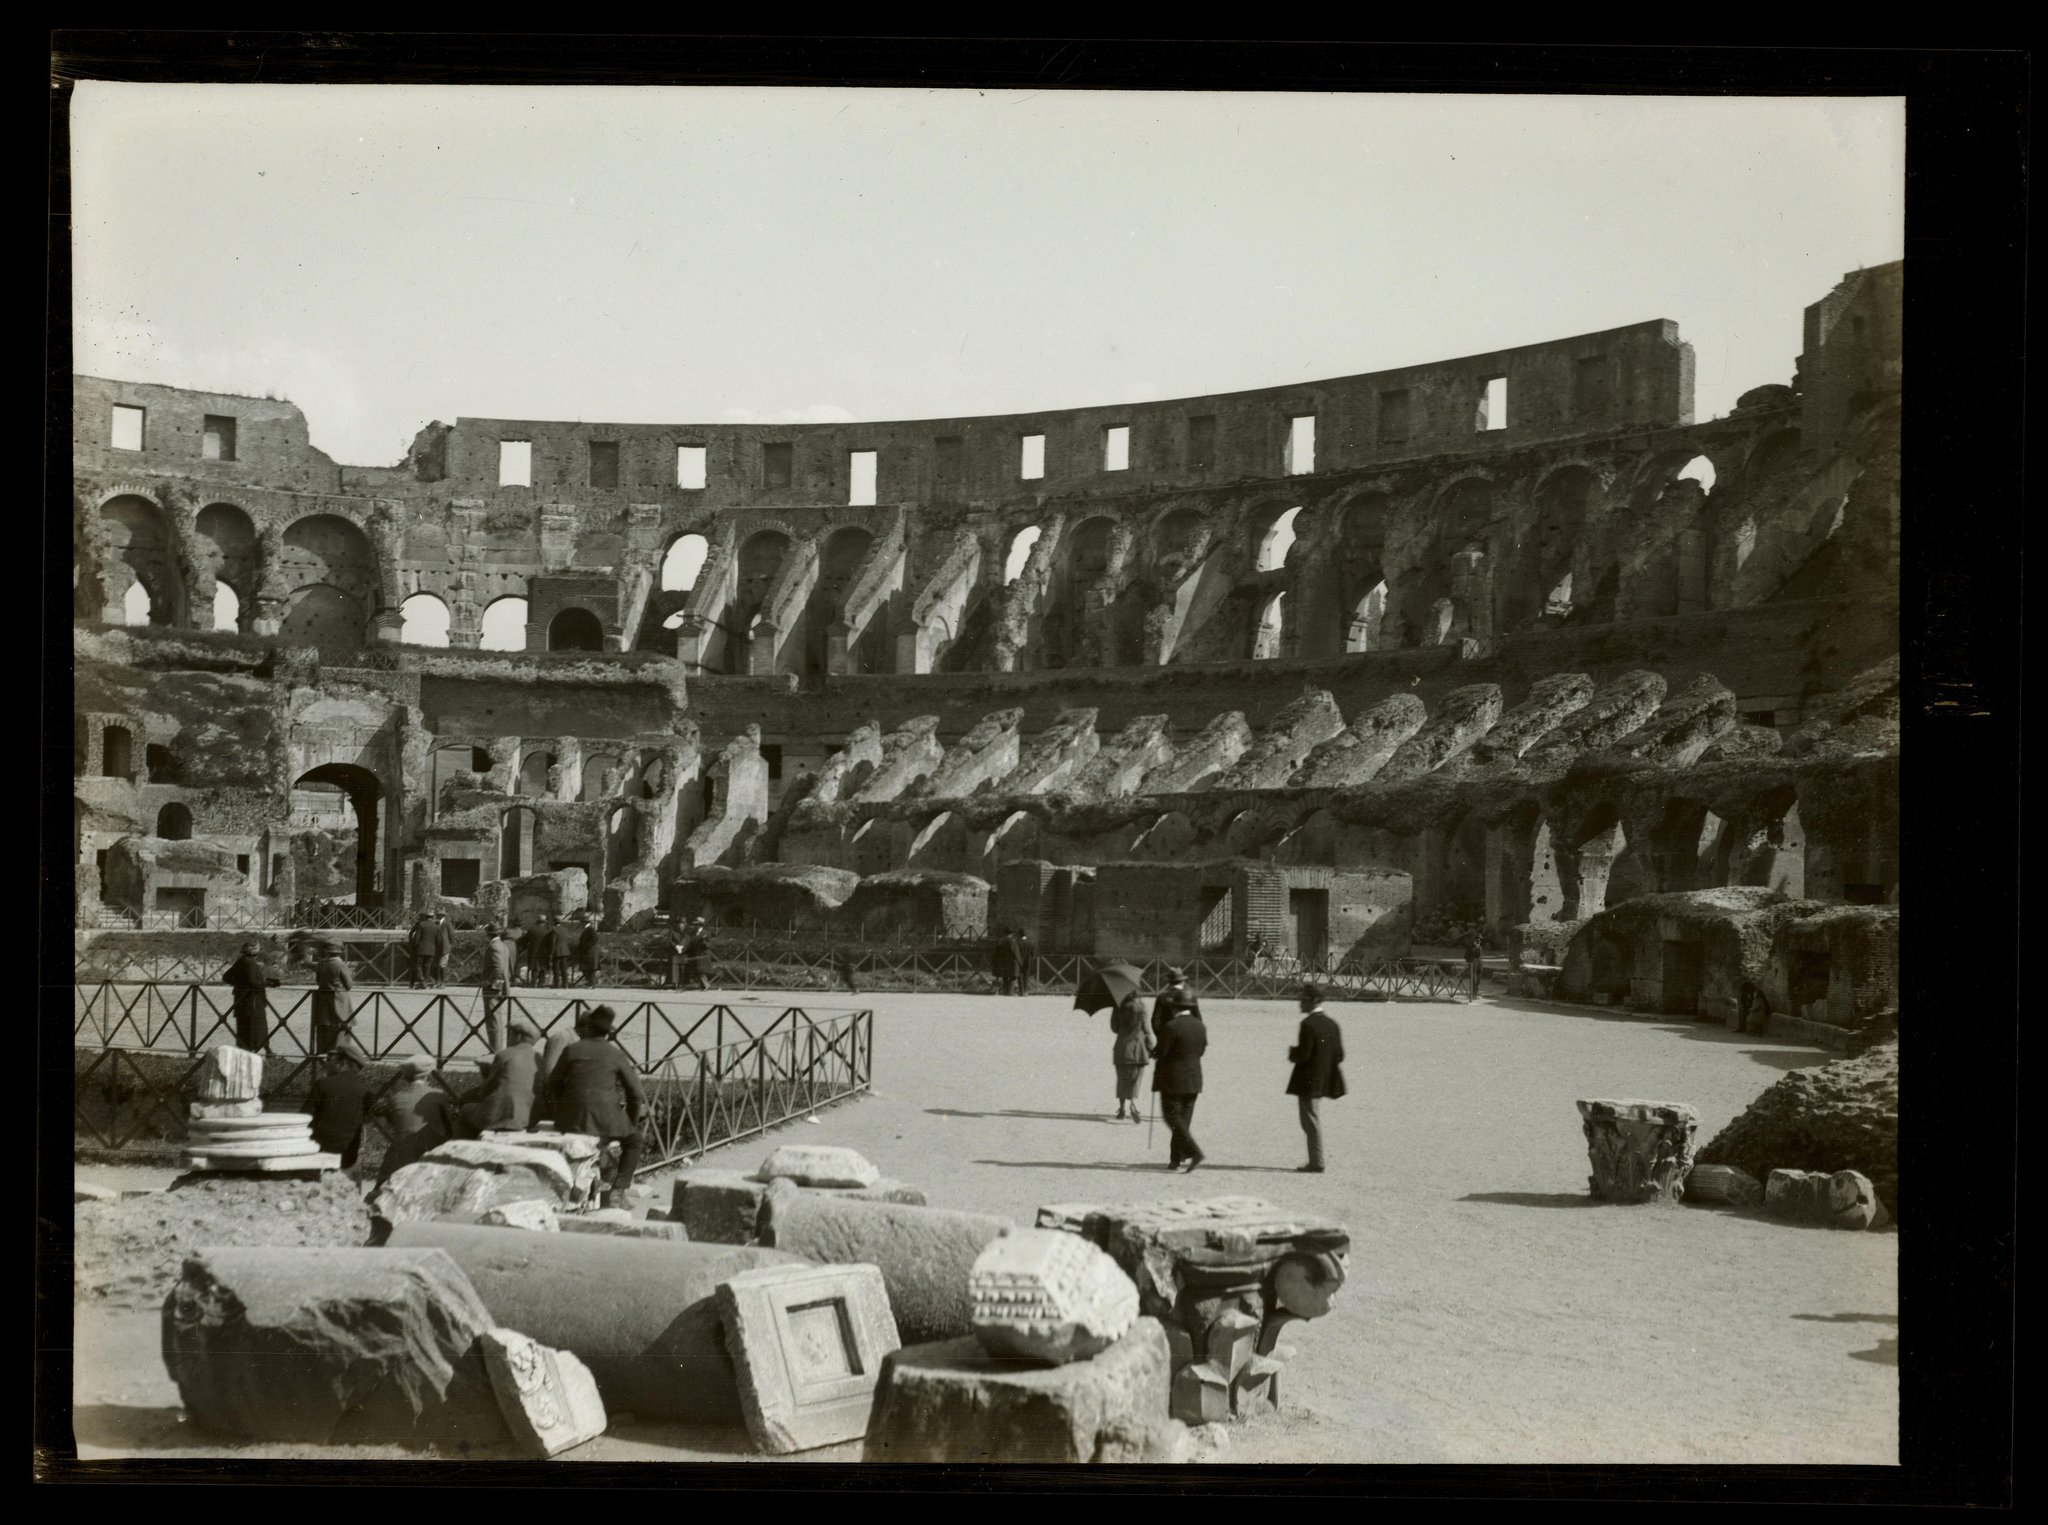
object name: negative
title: Filmnegatief met opname van Rome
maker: Anonymous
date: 1907-1935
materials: film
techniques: gelatin silver negative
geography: rome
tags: rome